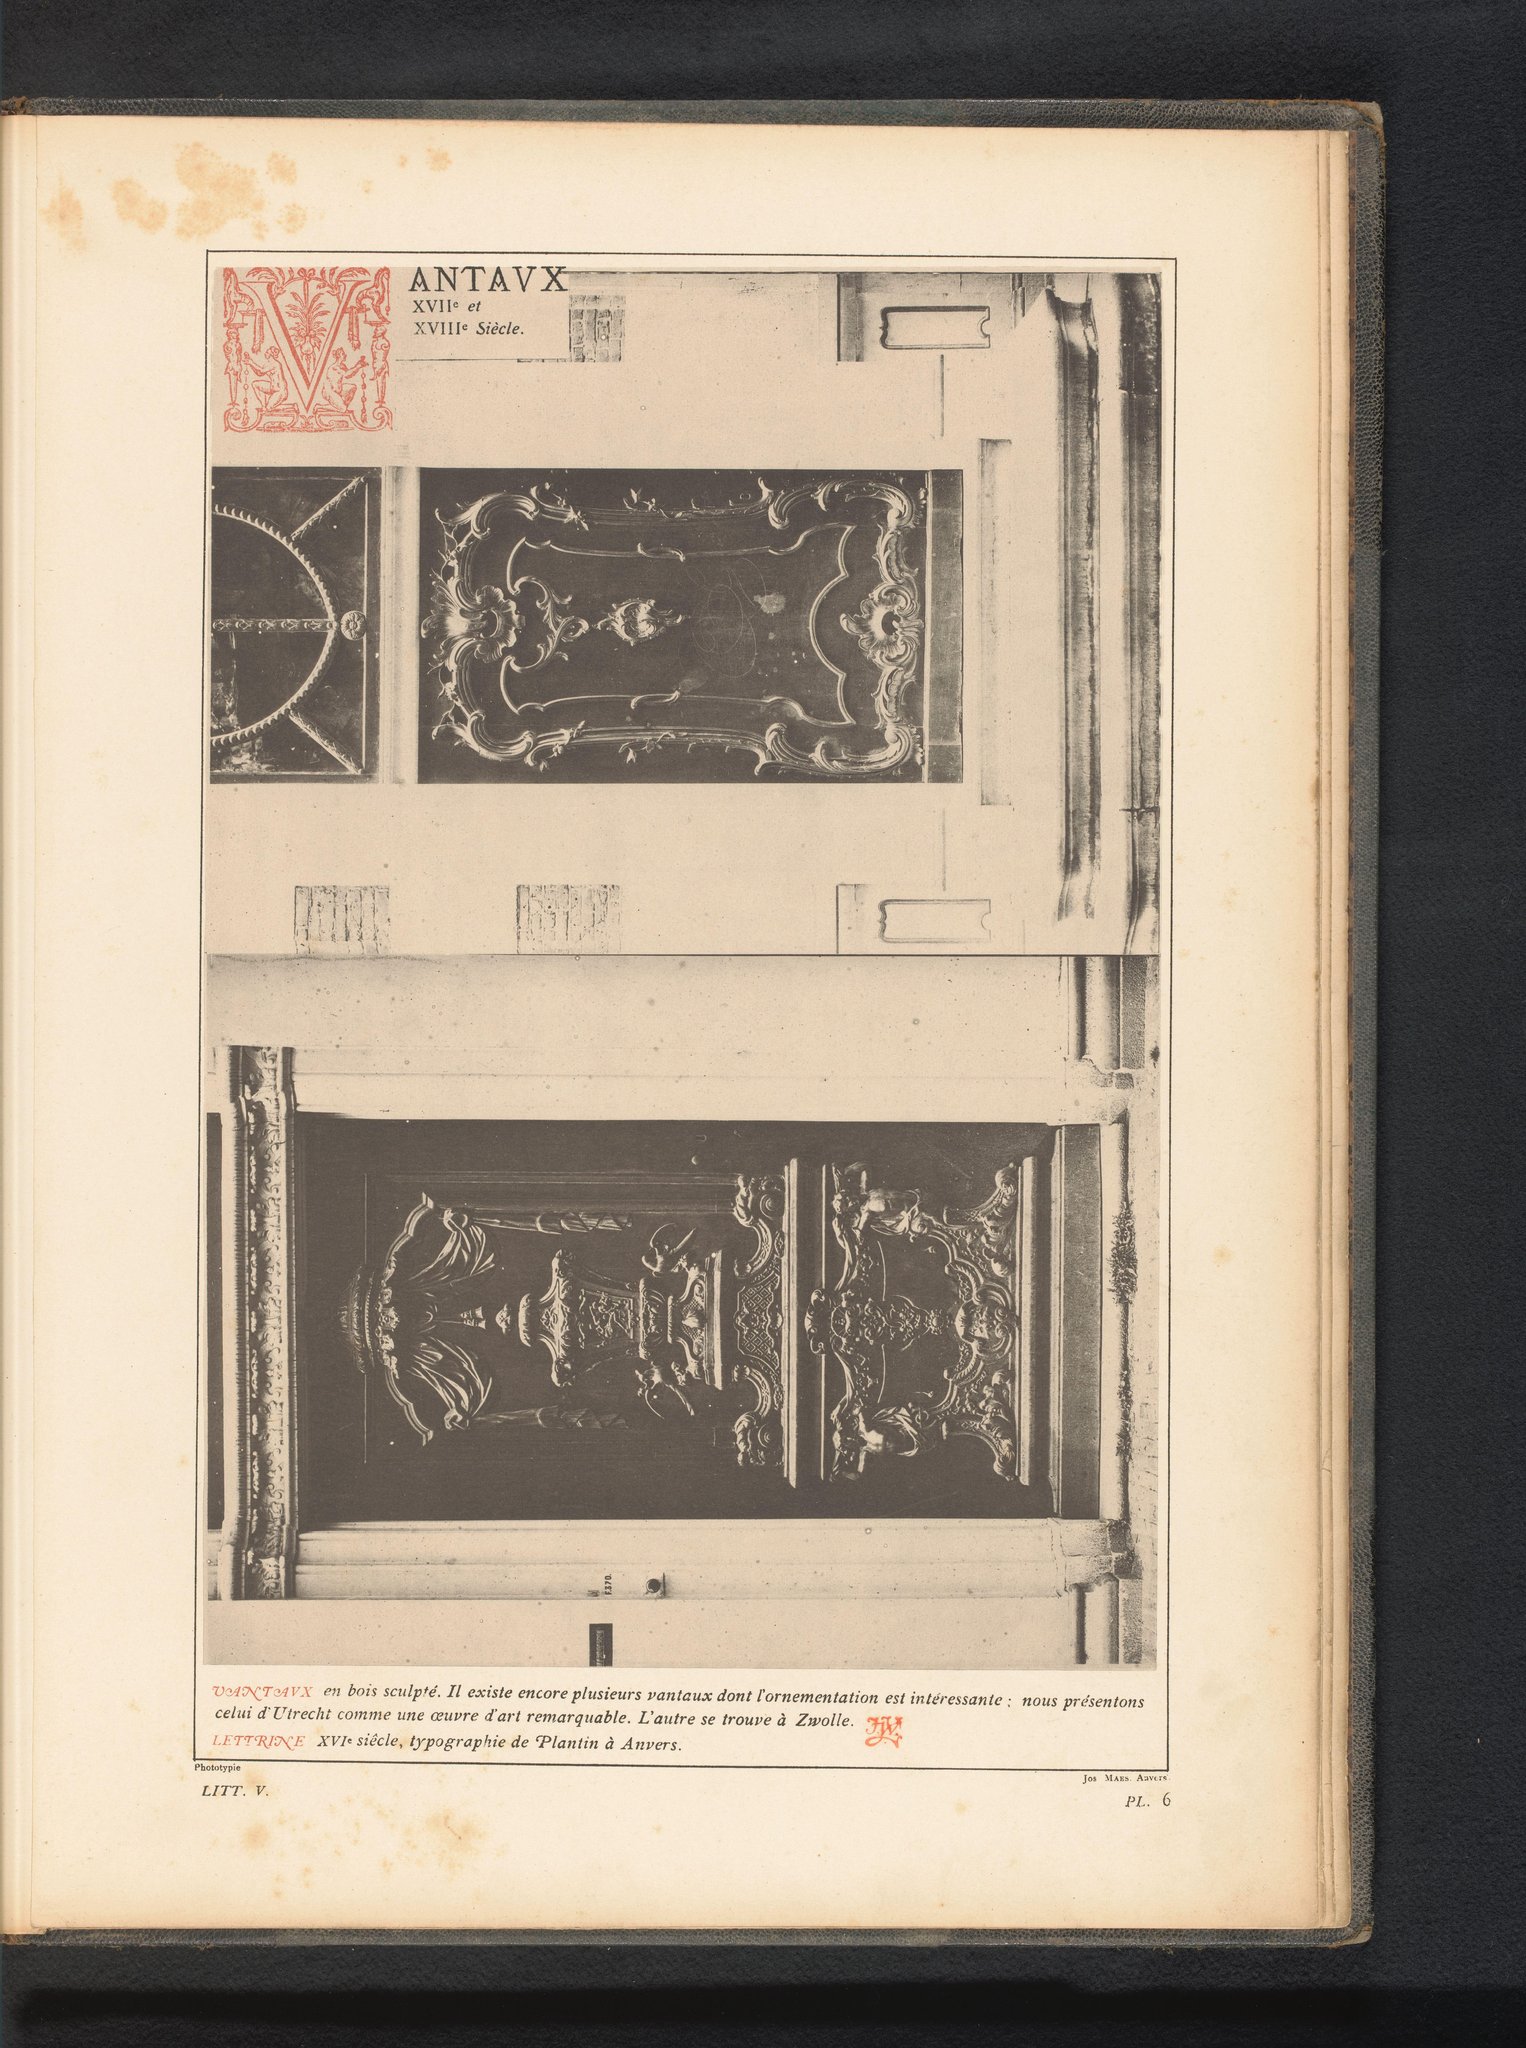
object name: page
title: Gedecoreerde deuren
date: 1876-1881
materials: paper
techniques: photograph, photolithography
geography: antwerp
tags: door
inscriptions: inscription: ‘VANTAUX en bois (...)’, monogram: ‘JJvY’, inscription: ‘LITT. V. - PL. 6.’